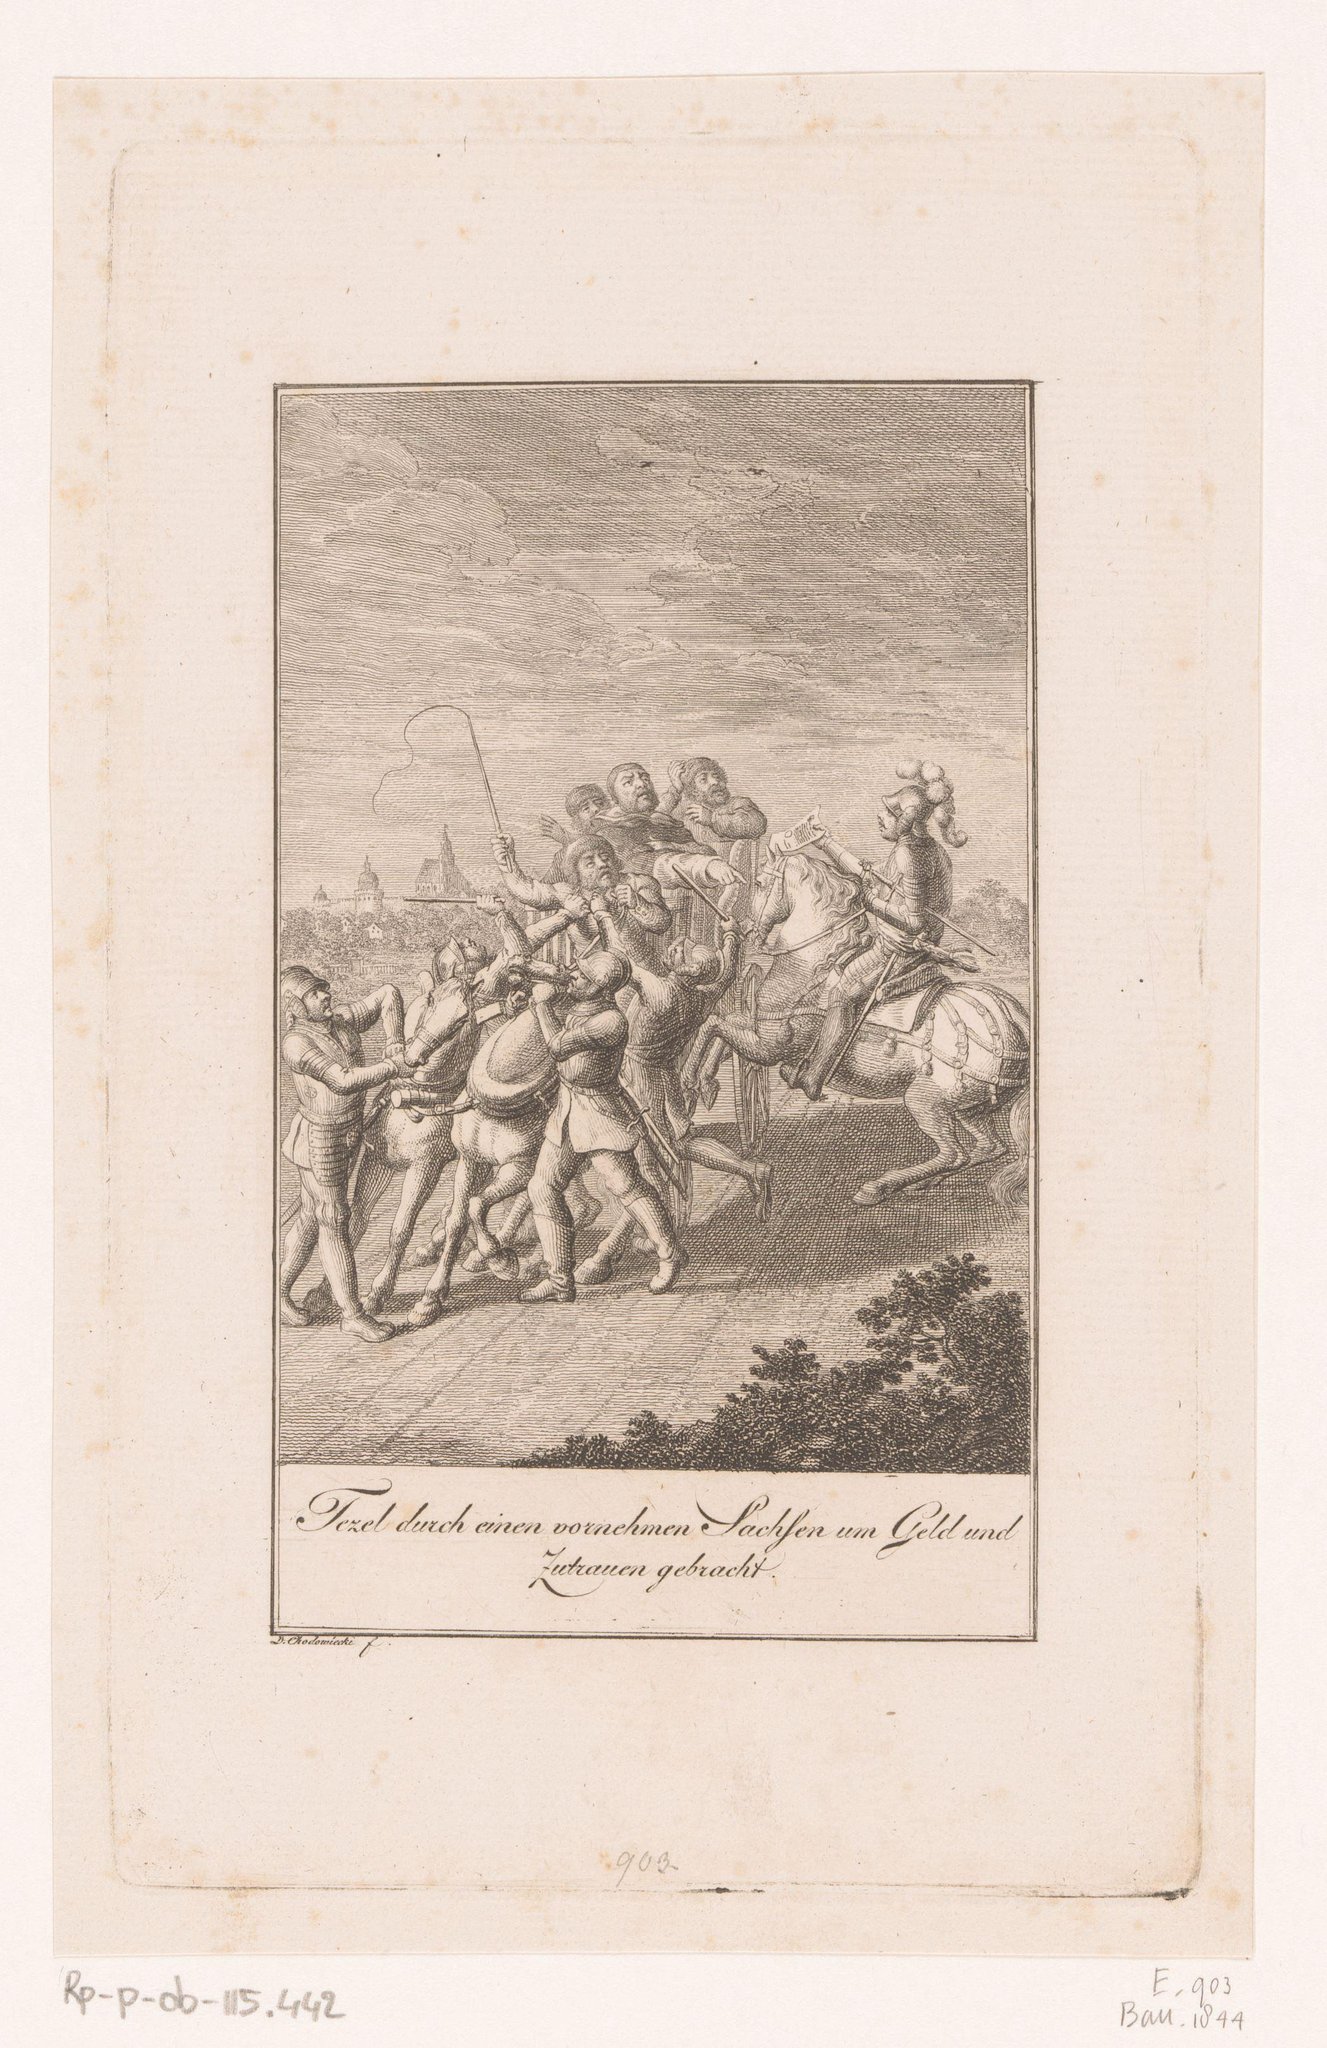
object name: print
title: Johannes Tetzel wordt nabij Leipzig overvallen en beschuldigd aflatenhandel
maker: daniel nikolaus chodowiecki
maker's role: draughtsman, print maker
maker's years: 1726-1801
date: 1798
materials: paper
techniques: etching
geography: berlin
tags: history, monk(s), friar(s), arrest (of criminal), indulgence, clemency; 'clemenza', 'clemenza & moderatione', 'indulgenza' (ripa)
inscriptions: collector's mark: Lugt 2228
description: Prent gebruikt voor: Deutsche Monatsschrift (...). 3 dln. Leipzig: Sommersche Buchhandlung, 1798.